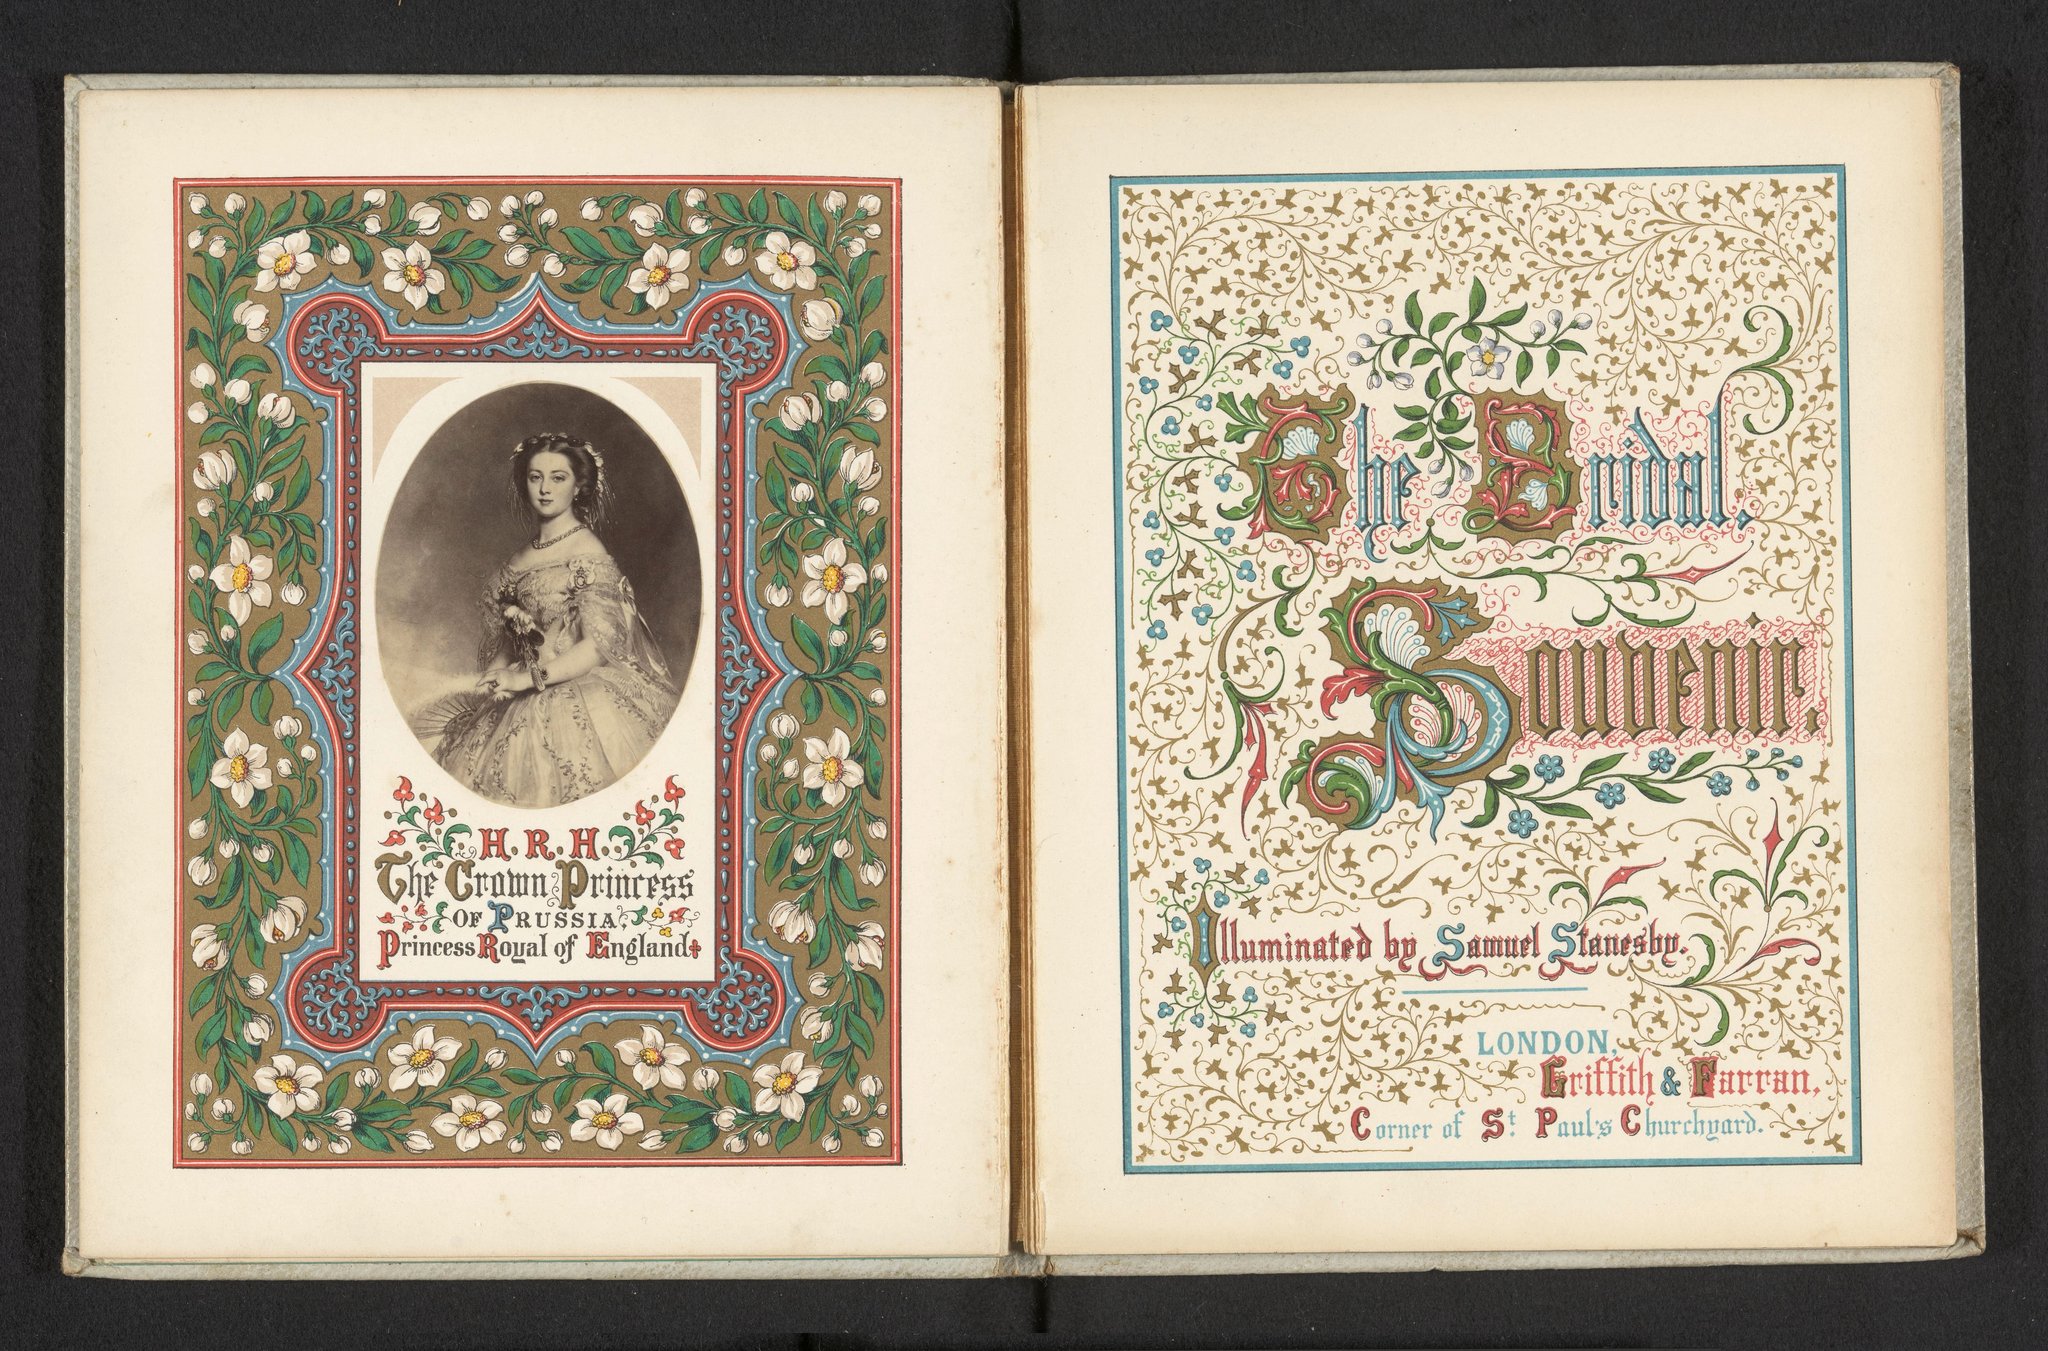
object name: photograph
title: H.R.H. The crown princess of Prussia princess royal of England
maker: Anonymous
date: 1853-1858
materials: photographic support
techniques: albumen print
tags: victoria van saksen-coburg en gotha (duits keizerin), princess